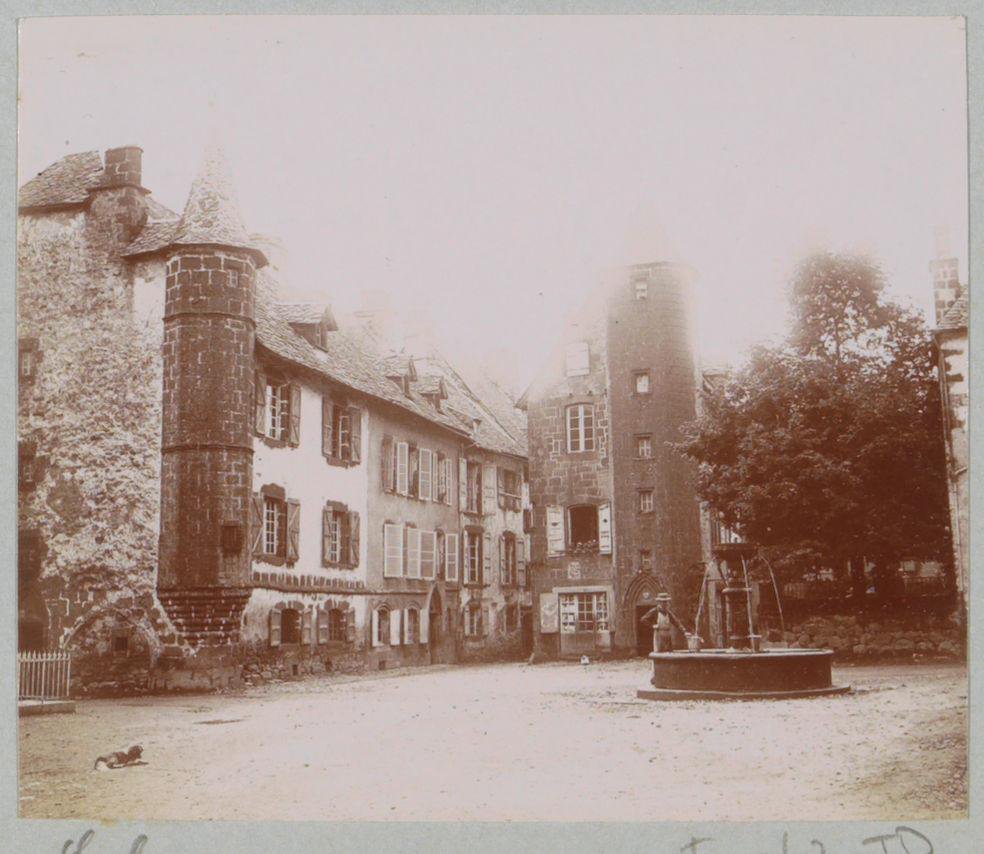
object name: photograph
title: Plein met fontein en torens in Salers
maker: delizy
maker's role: manufacturer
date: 1903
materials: paper, photographic support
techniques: gelatin silver print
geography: salers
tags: prospect of village, silhouette of village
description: Onderdeel van Fotoalbum van een Franse amateurfotograaf met opnames van uitstapjes in Frankrijk, Spanje, België, Luxemburg en Nederland, de eerste automobielen en autoraces.